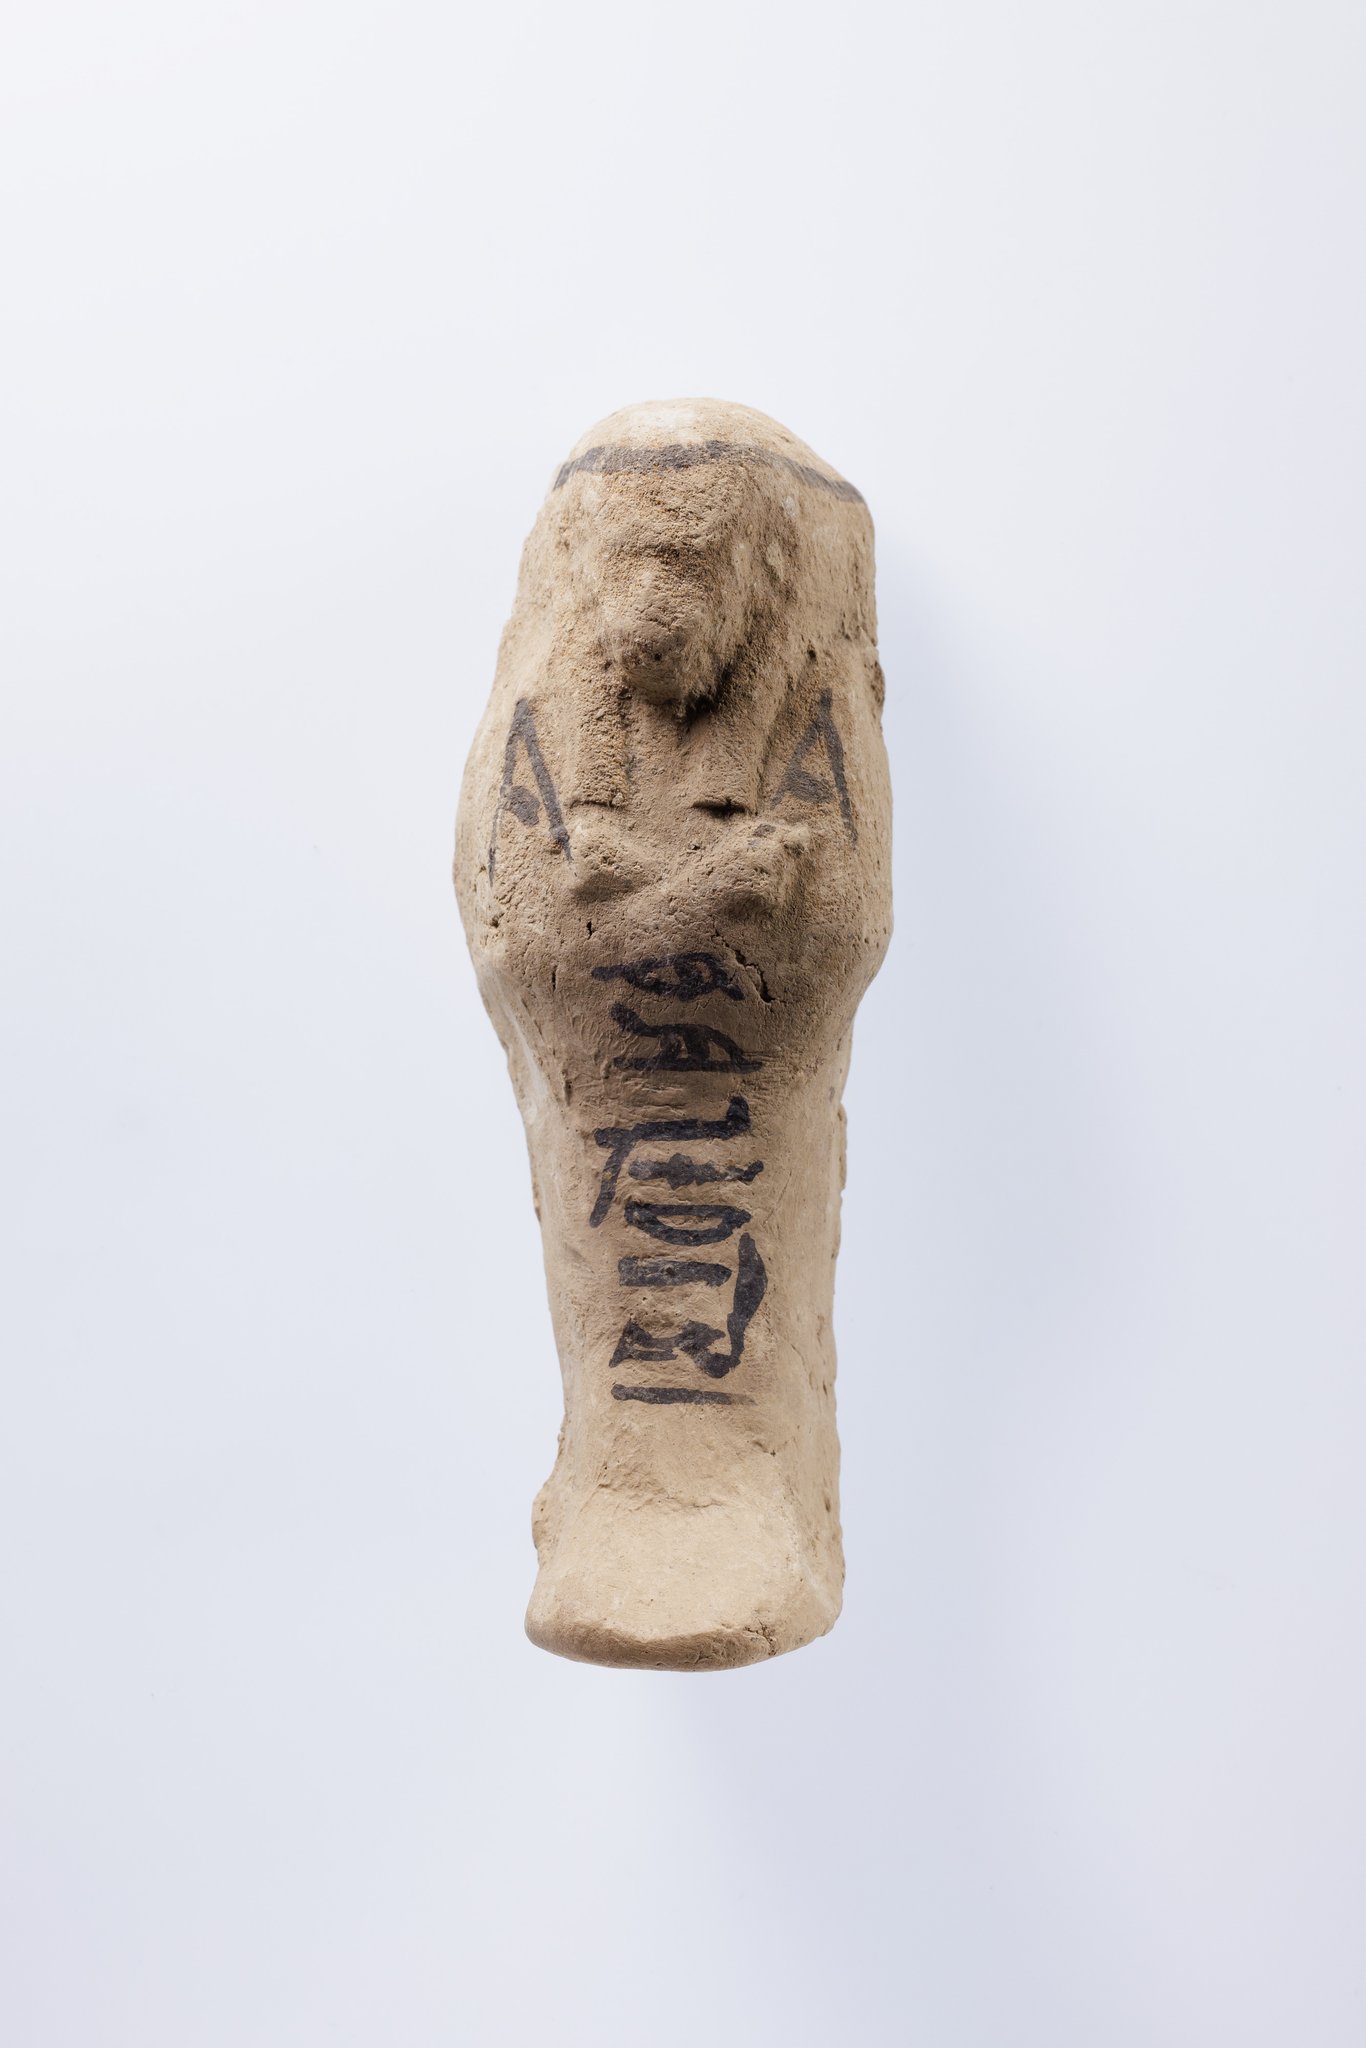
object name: shabti, nesinebtasheru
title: Shabti of Nesinebtasheru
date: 1070-945 BCE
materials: clay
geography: egypt